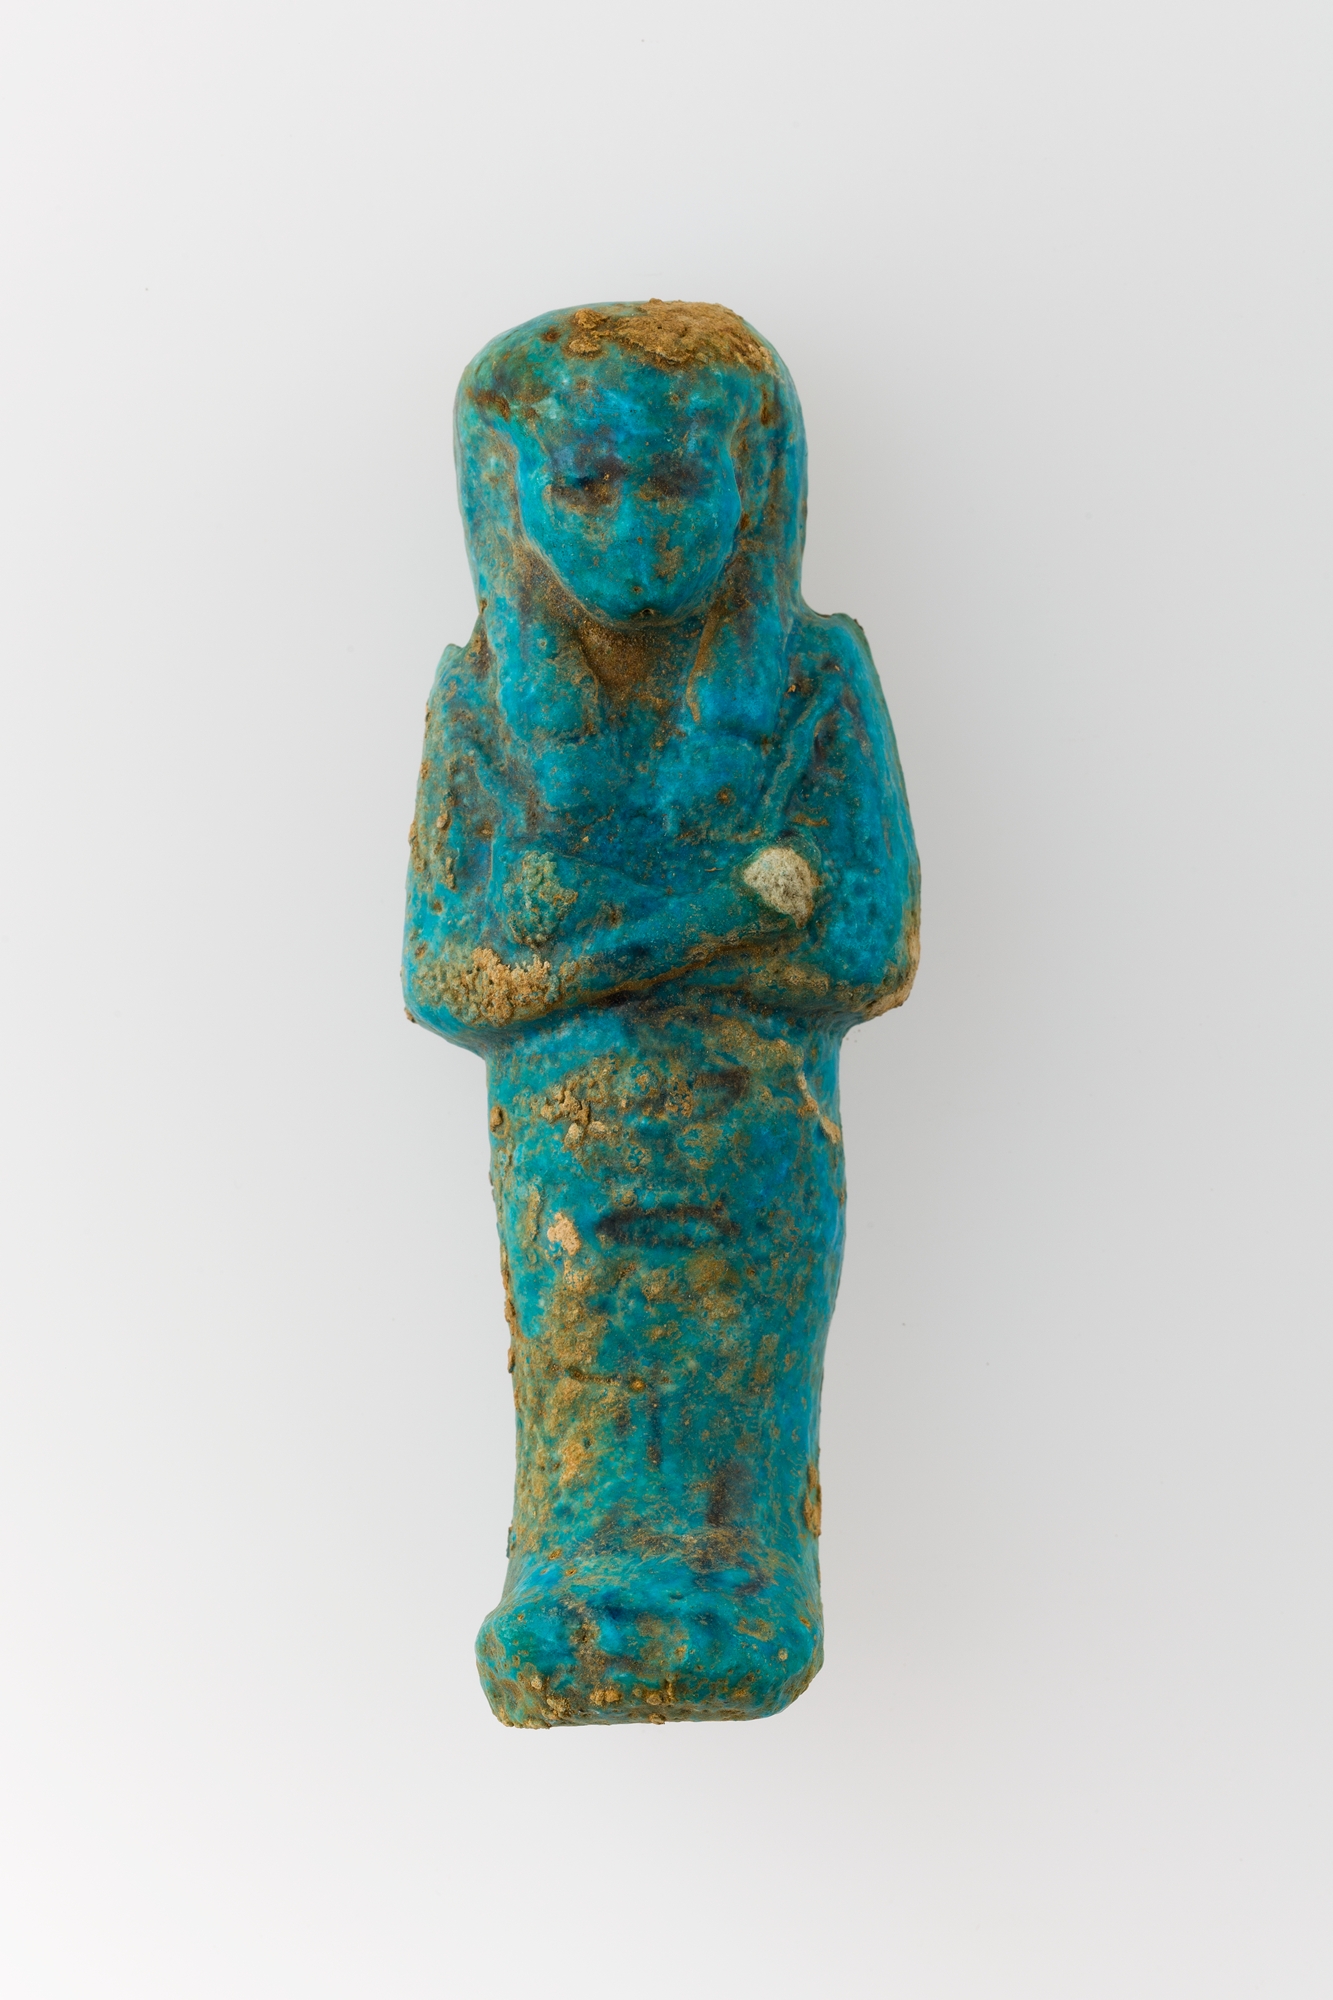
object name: shabti, henettawy c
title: Worker Shabti of Henettawy (C), Daughter of Isetemkheb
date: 990-970 BCE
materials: faience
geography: egypt